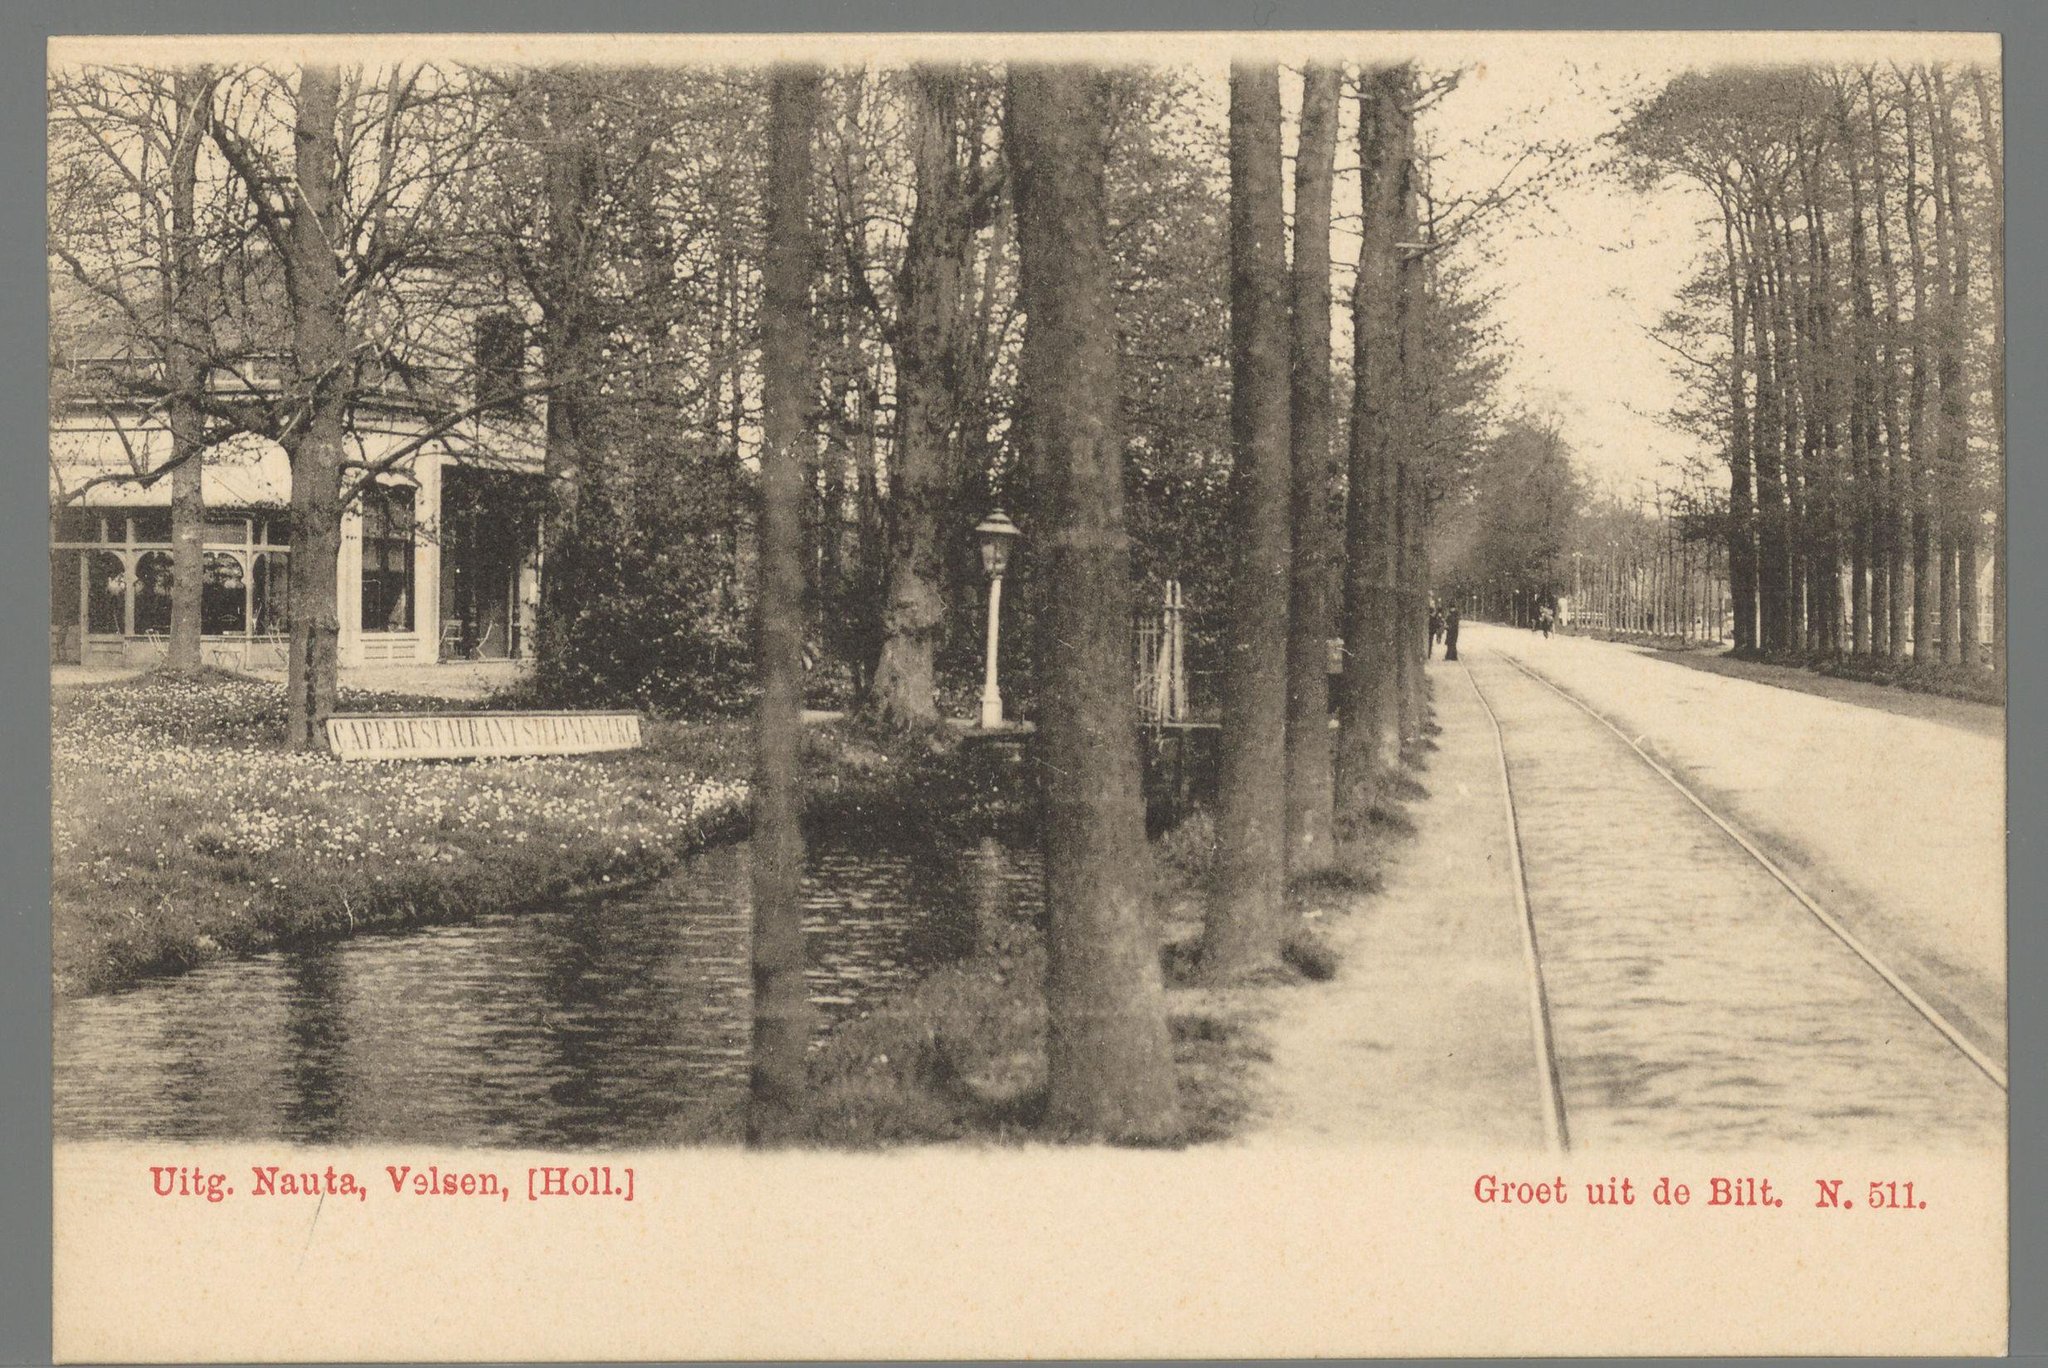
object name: ansichtkaart, prentbriefkaart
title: Groet uit de Bilt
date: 1897-1905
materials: cardboard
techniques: photograph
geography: velsen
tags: canals, waters (in village), restaurant